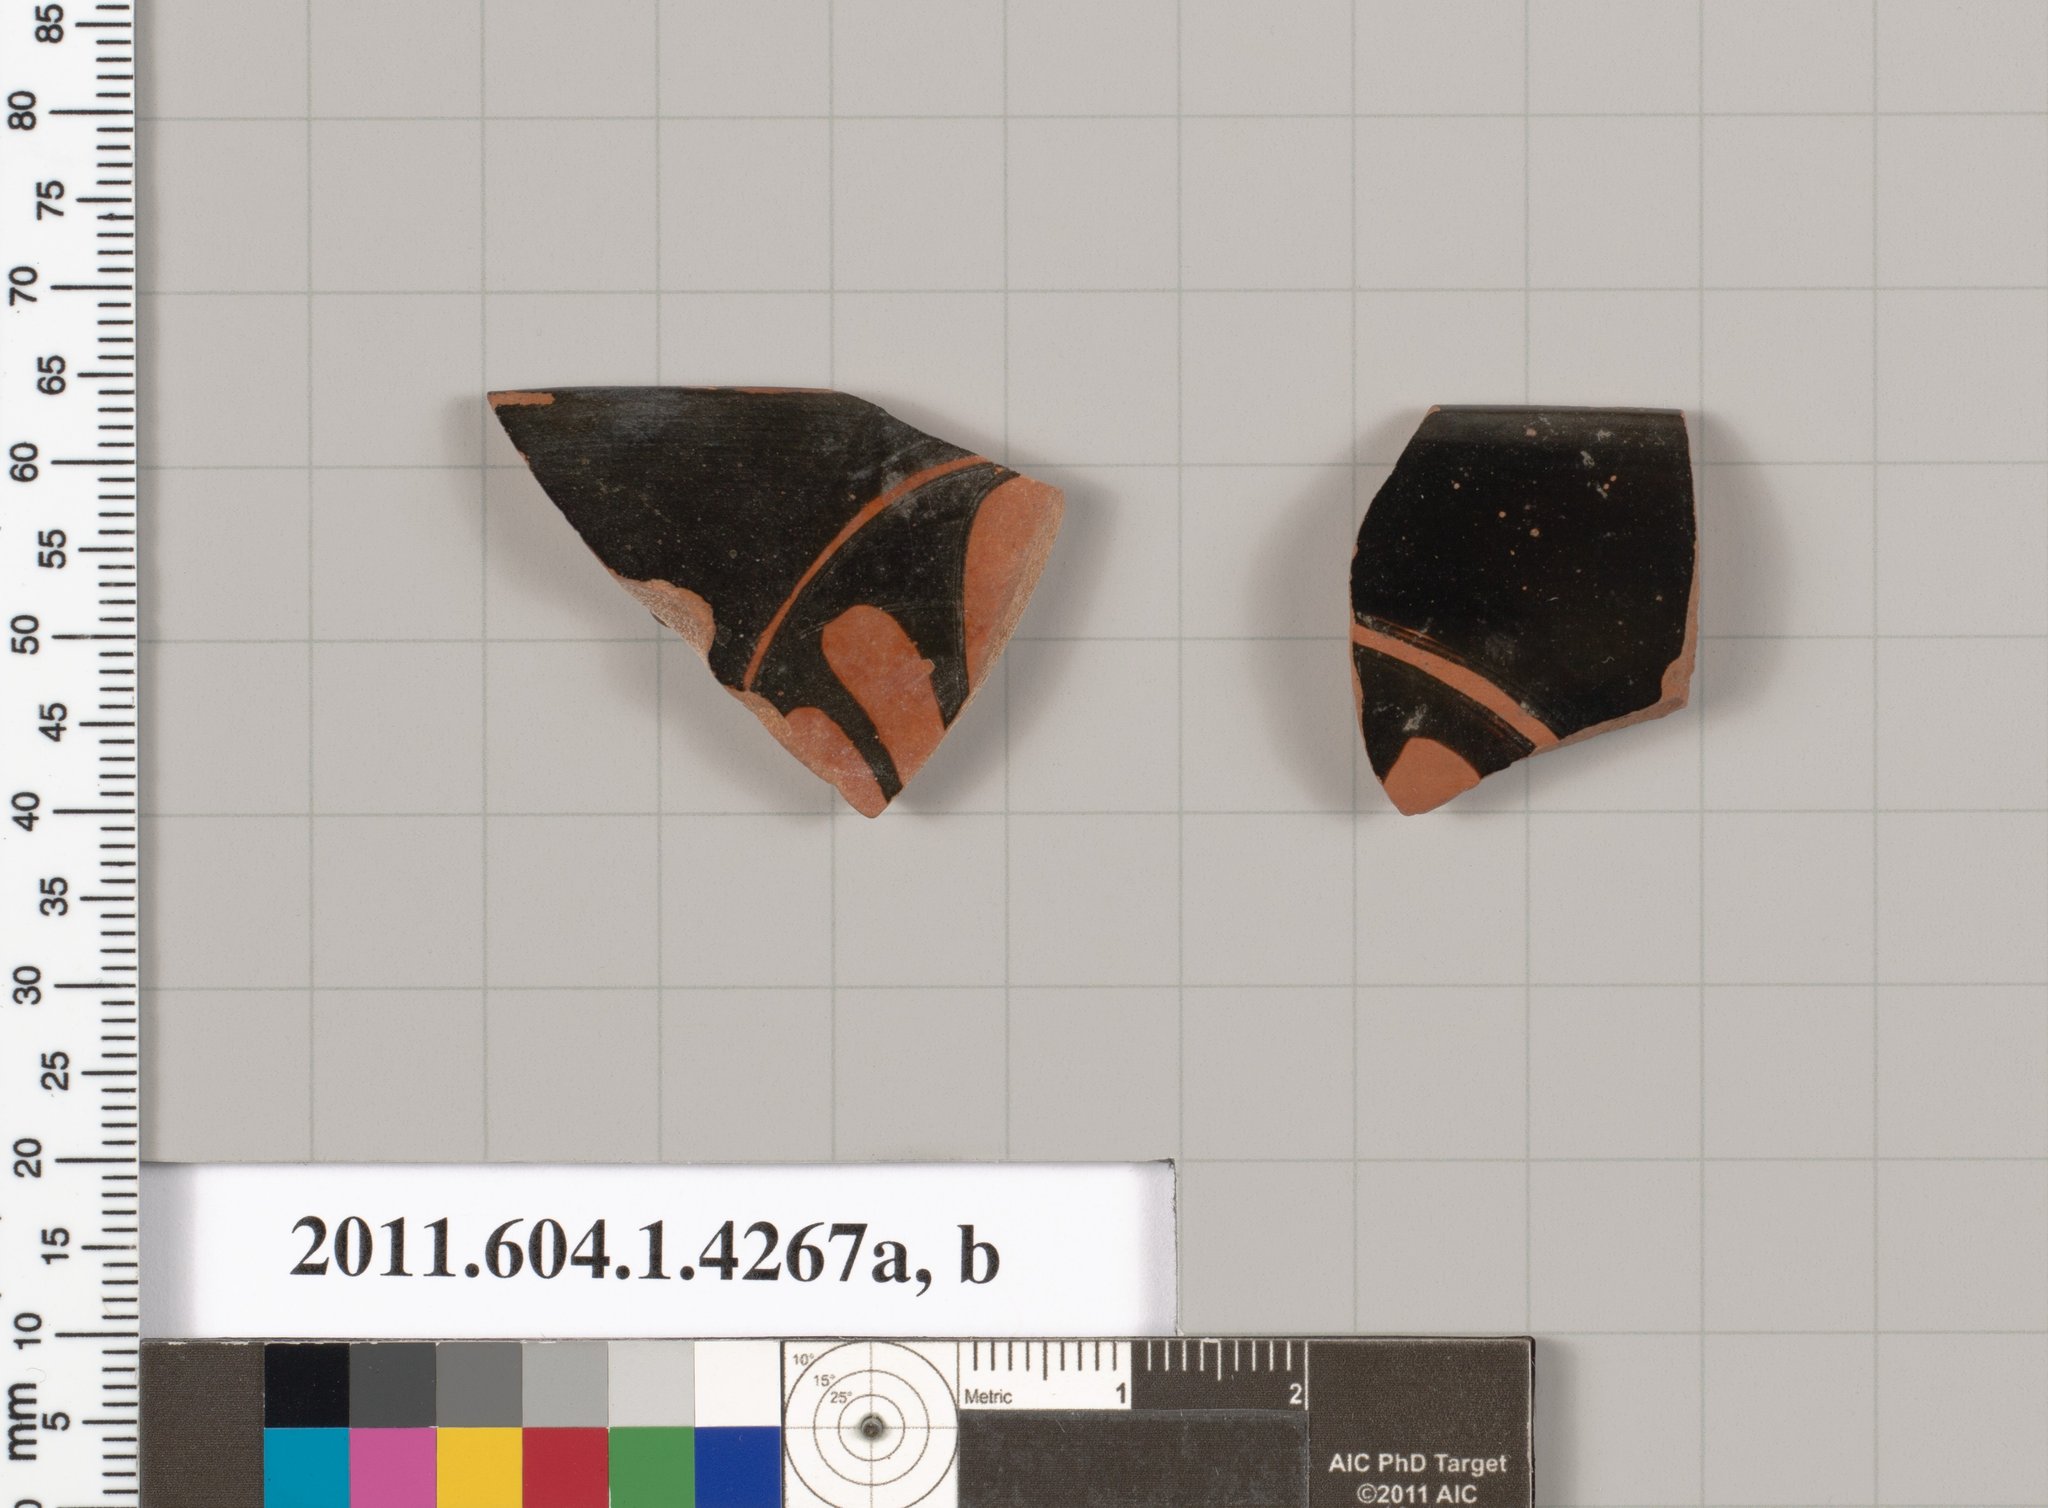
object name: kylix fragment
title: Terracotta rim fragments of kylikes (drinking cups)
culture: greek, attic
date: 500-476 BCE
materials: terracotta